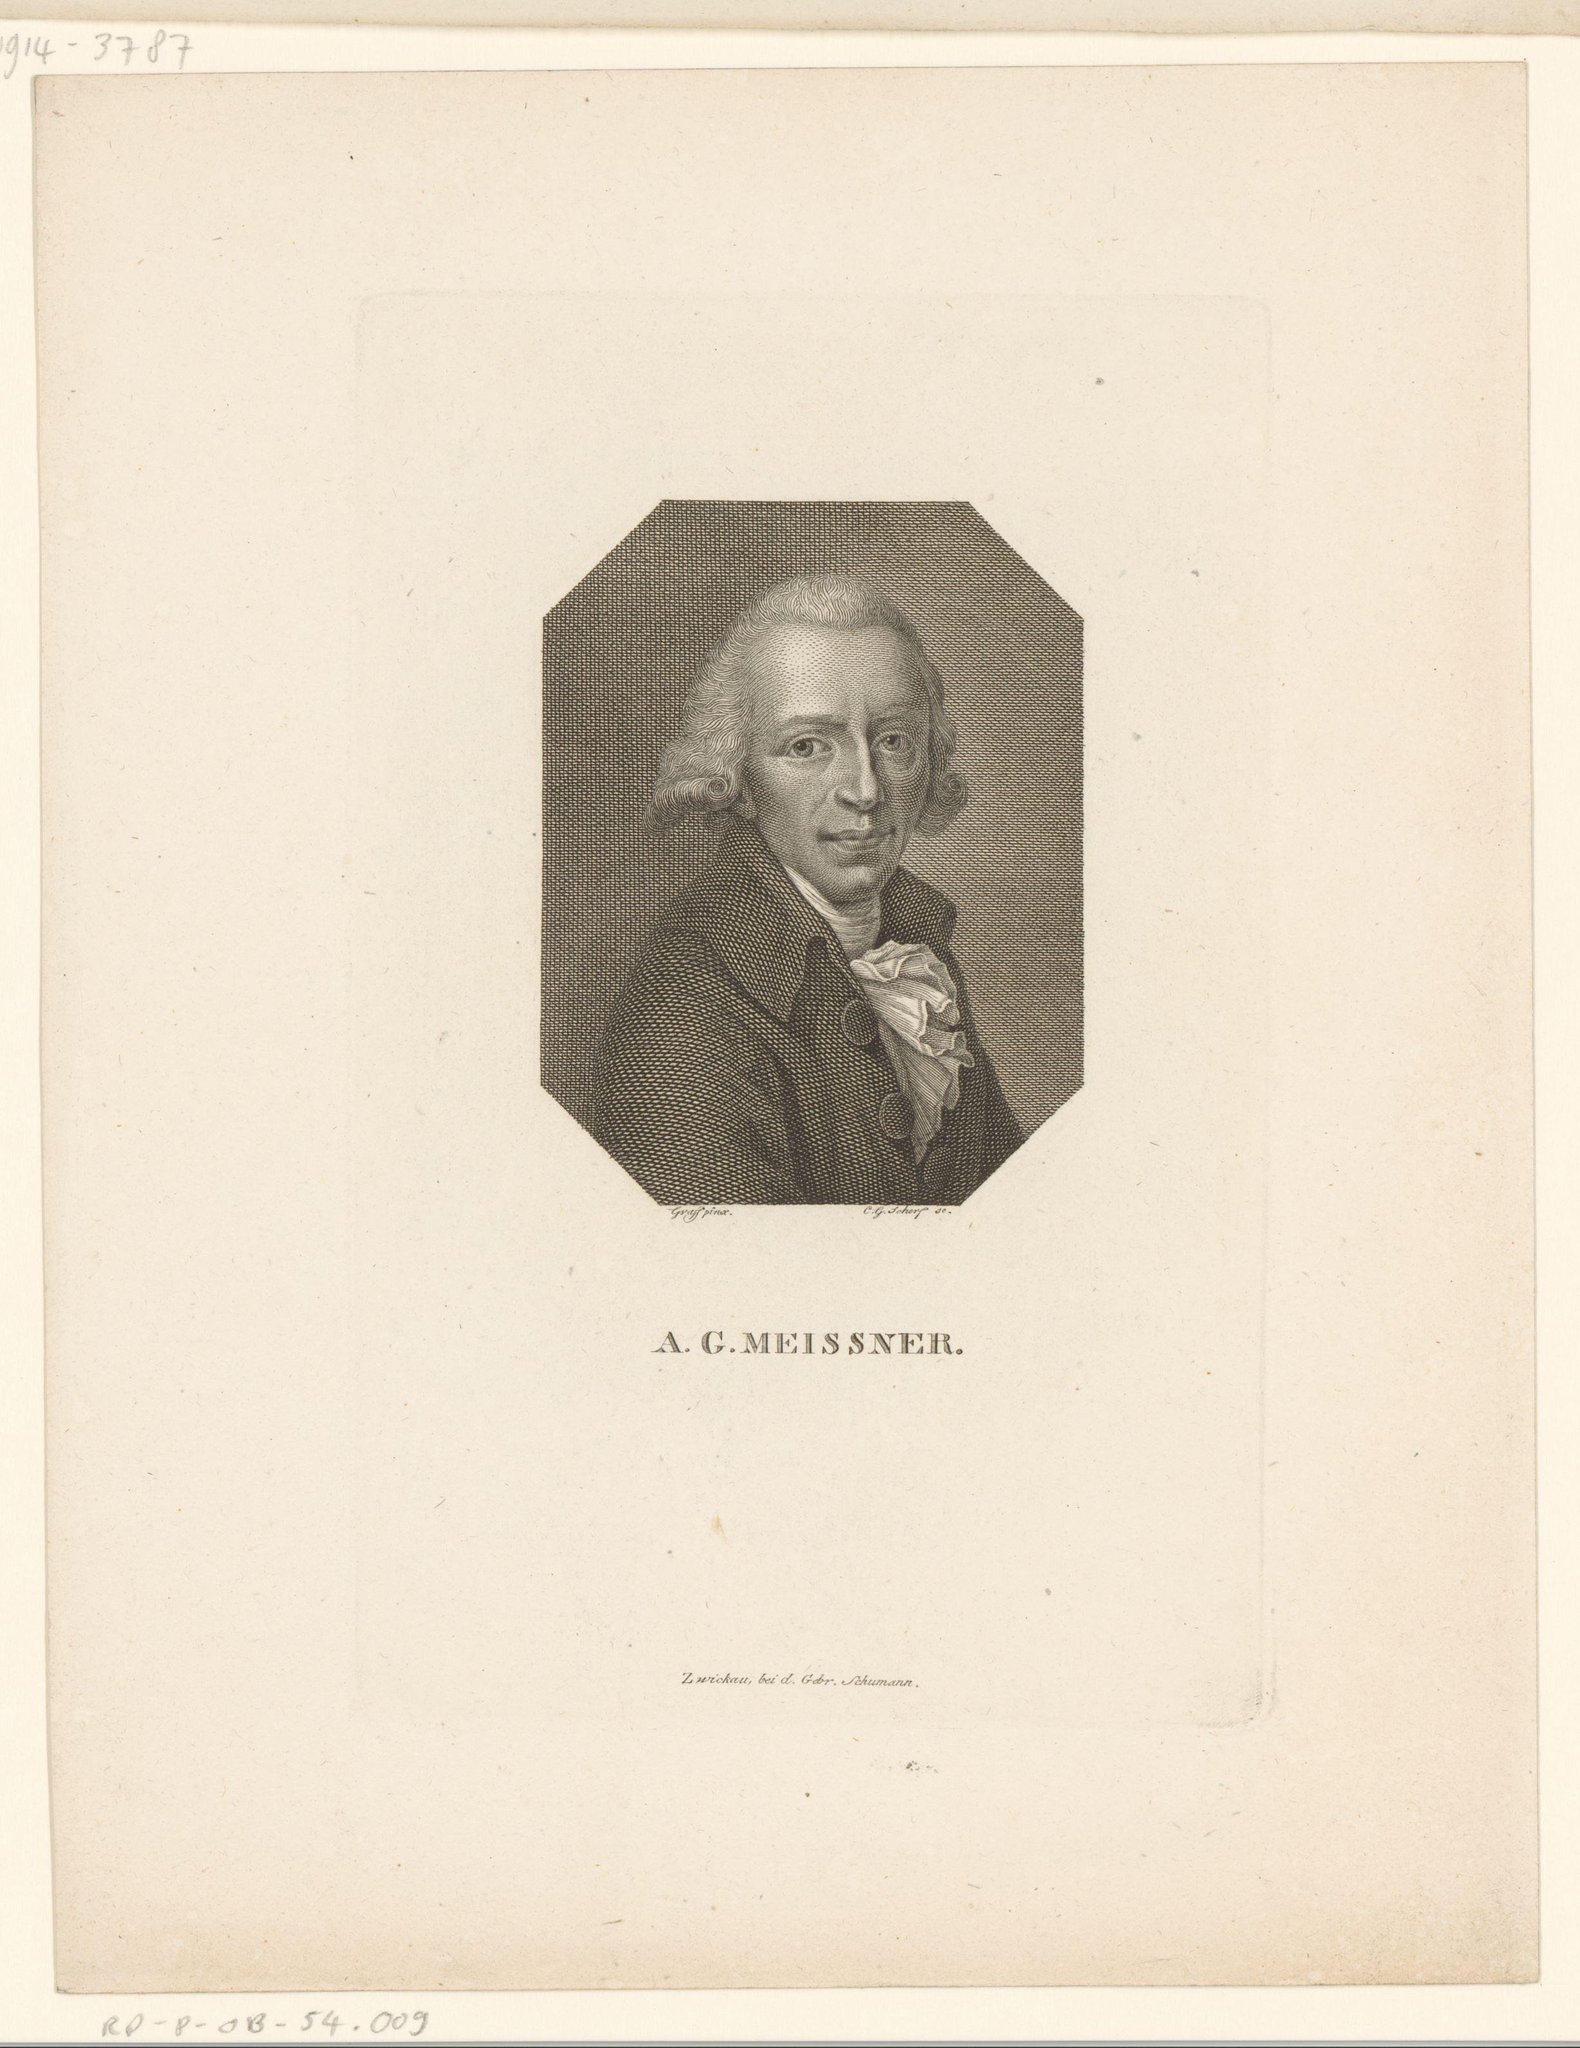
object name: print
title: Portret van August Gottlieb Meissner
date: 1803-1849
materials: paper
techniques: engraving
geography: zwickau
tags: historical persons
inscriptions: collector's mark: Lugt 2228